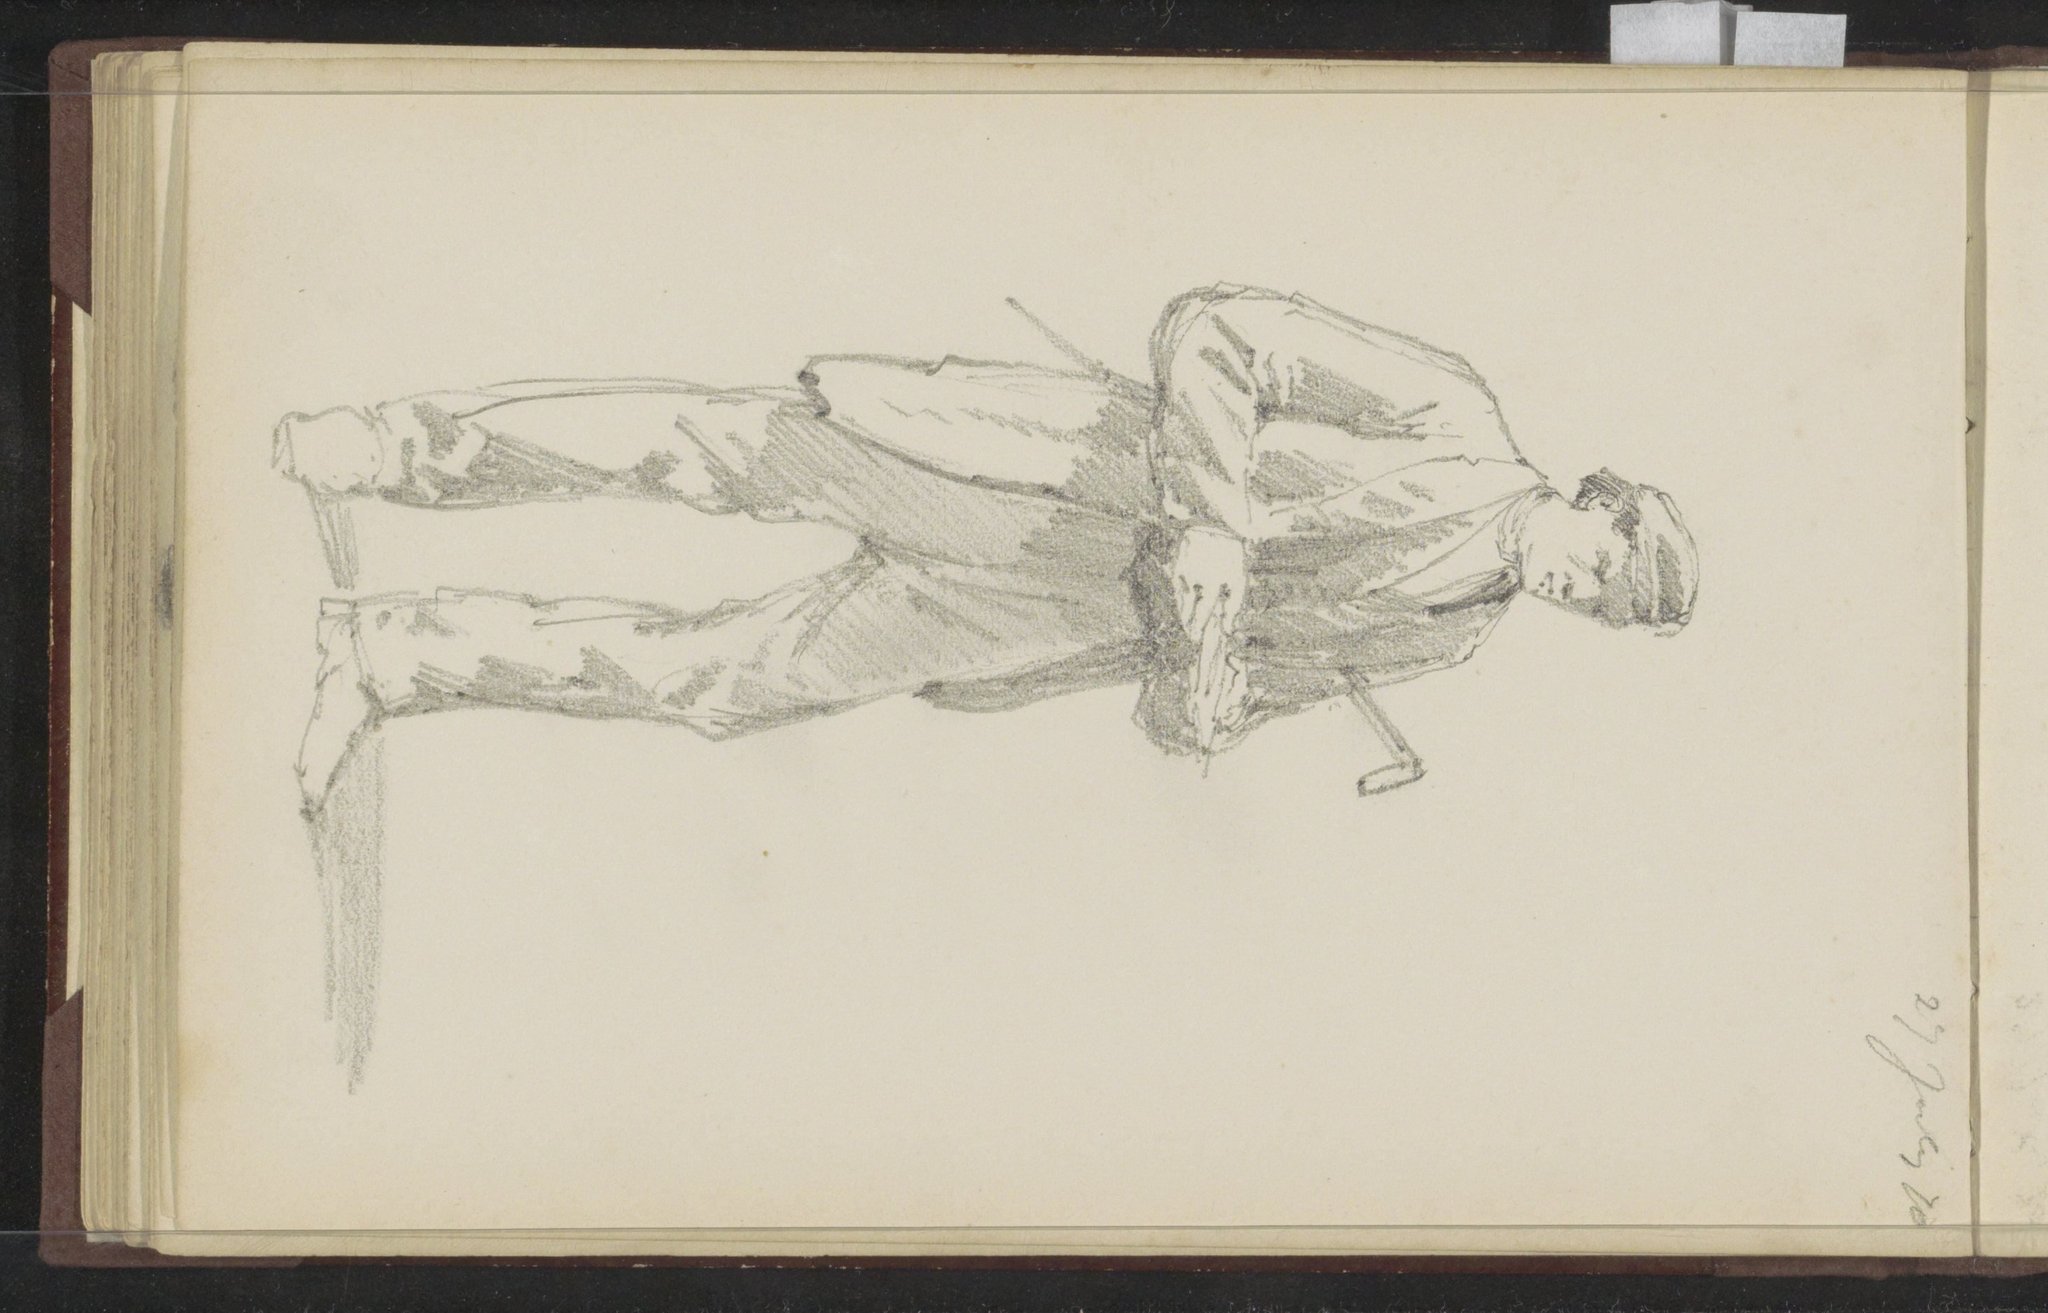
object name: sketchbook leaf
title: Man met een stok onder zijn arm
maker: cornelis springer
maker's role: draughtsman, painter, print maker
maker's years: 1817-1891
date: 1870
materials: paper, pencil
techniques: stumping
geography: netherlands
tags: walking-stick, staff, adult man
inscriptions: date: ‘27 July 70’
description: Man met een stok onder zijn arm. In zijn handen heeft hij mogelijk papier. Blad 23 verso uit een schetsboek met 39 bladen, deels vervaardigd te Ulm en Leiden.